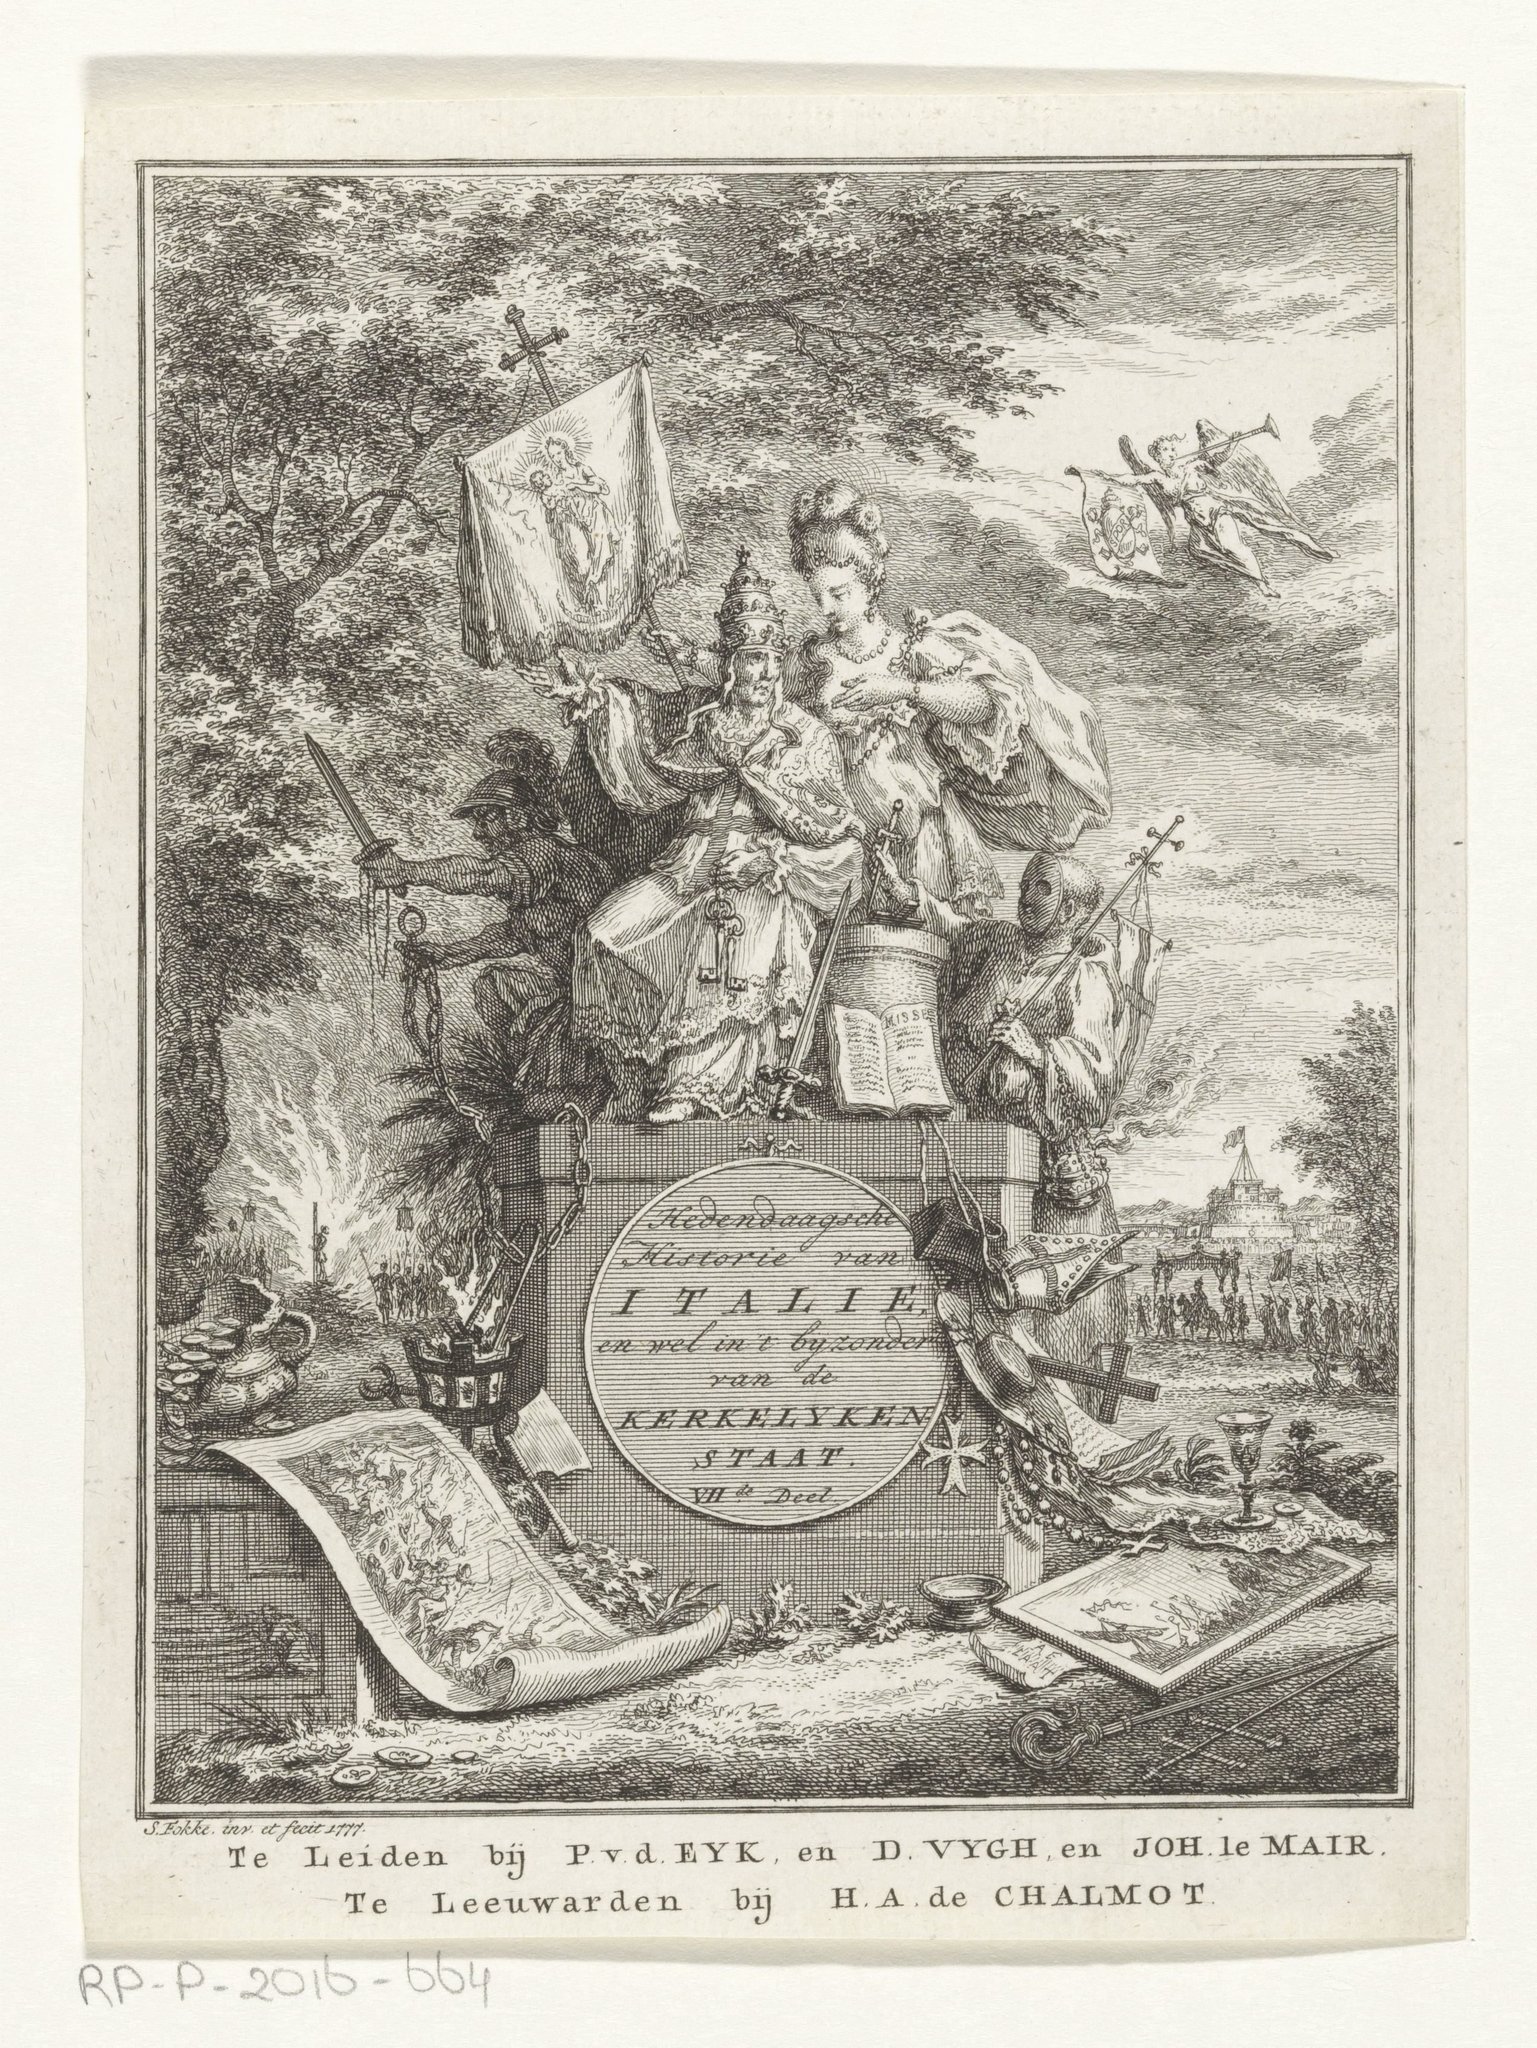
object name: print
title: Titelpagina voor: S.n., Hedendaagsche historie of Het vervolg van de Algemeene historie, 1777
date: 1777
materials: paper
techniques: engraving, etching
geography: leiden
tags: personifications of countries, nations, states, districts, etc., pride; 'superbia' (ripa) ~ personification of one of the seven deadly sins, pope, italy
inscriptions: collector's mark: Lugt 2228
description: Een paus zit op een voetstuk. De Hoogmoed fluistert hem iets in het oor, in haar hand houdt zij een vlag met Madonna. Links en rechts van hem zitten een gewapende soldaat en een gemaskerde monnik. Links in de achtergrond wordt een ketter verbrand. Rechts in de achtergrond een kruisvaart.